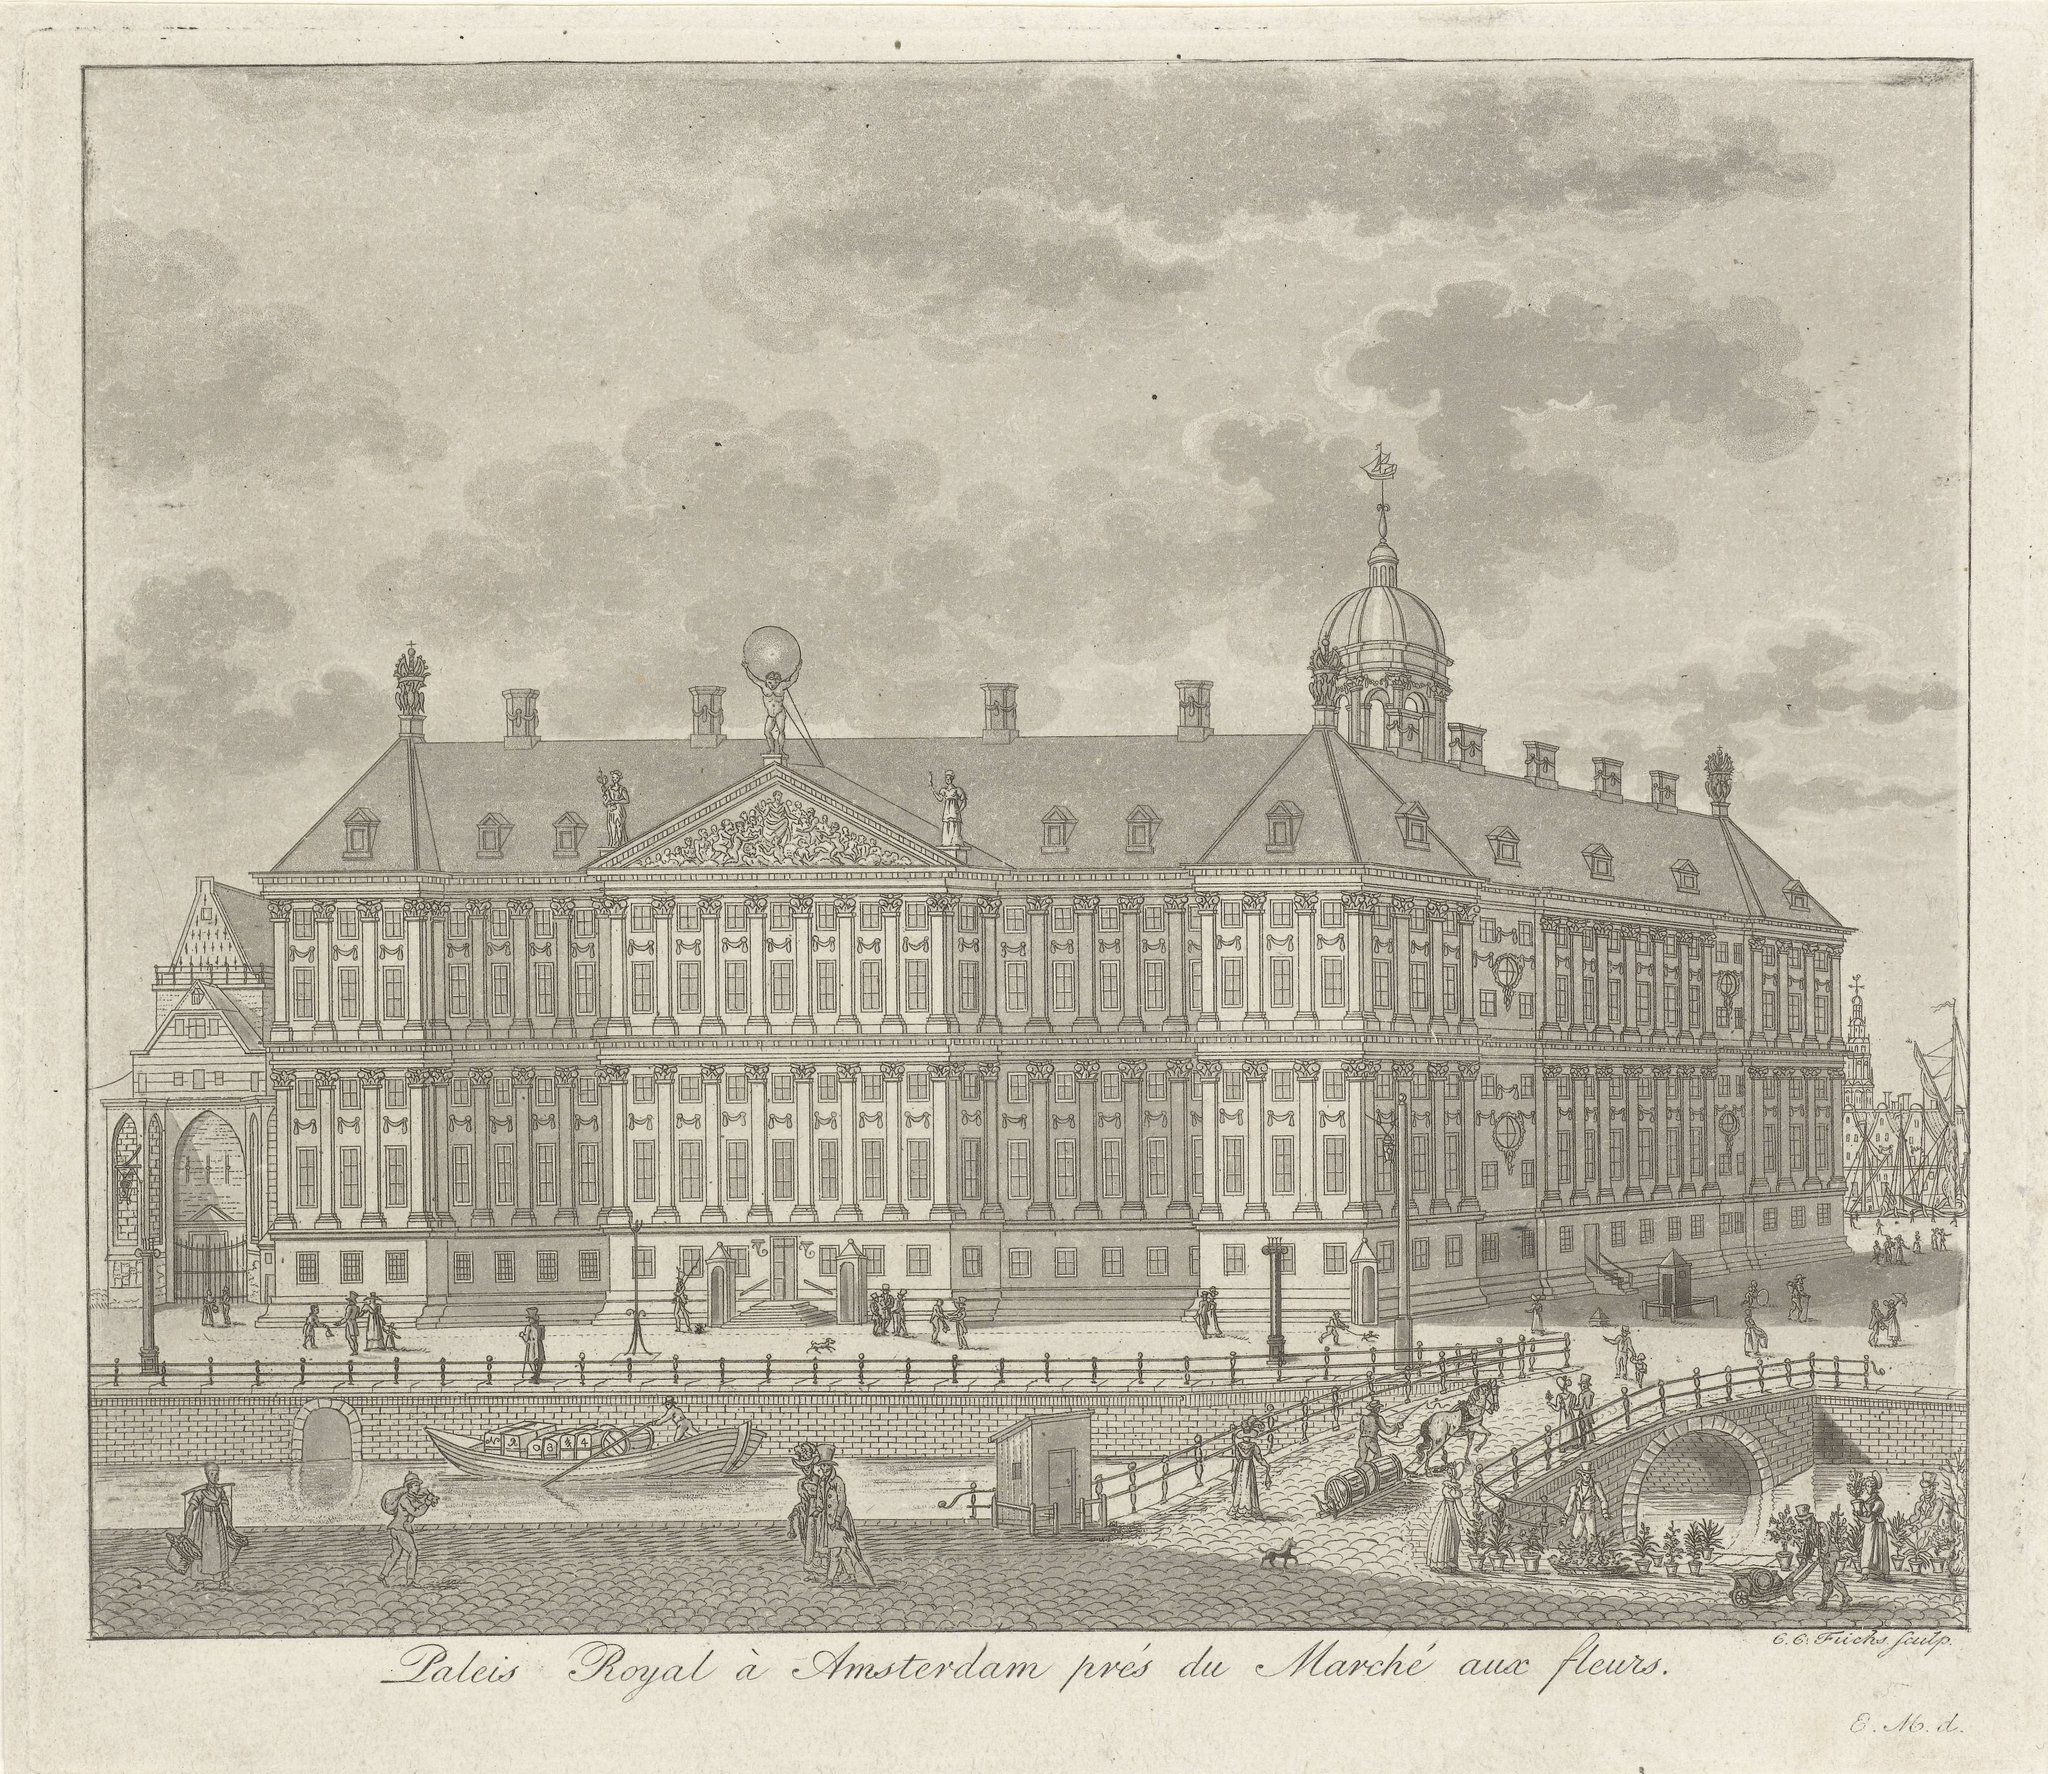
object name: print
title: Koninklijk Paleis te Amsterdam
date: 1808-1855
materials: paper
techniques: aquatint, etching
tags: palace, townhall, royal palace of amsterdam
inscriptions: collector's mark: Lugt 2228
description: Koninklijk Paleis te Amsterdam, dichtbij de Bloemenmarkt. Onder de afbeelding een regel tekst in het Frans.